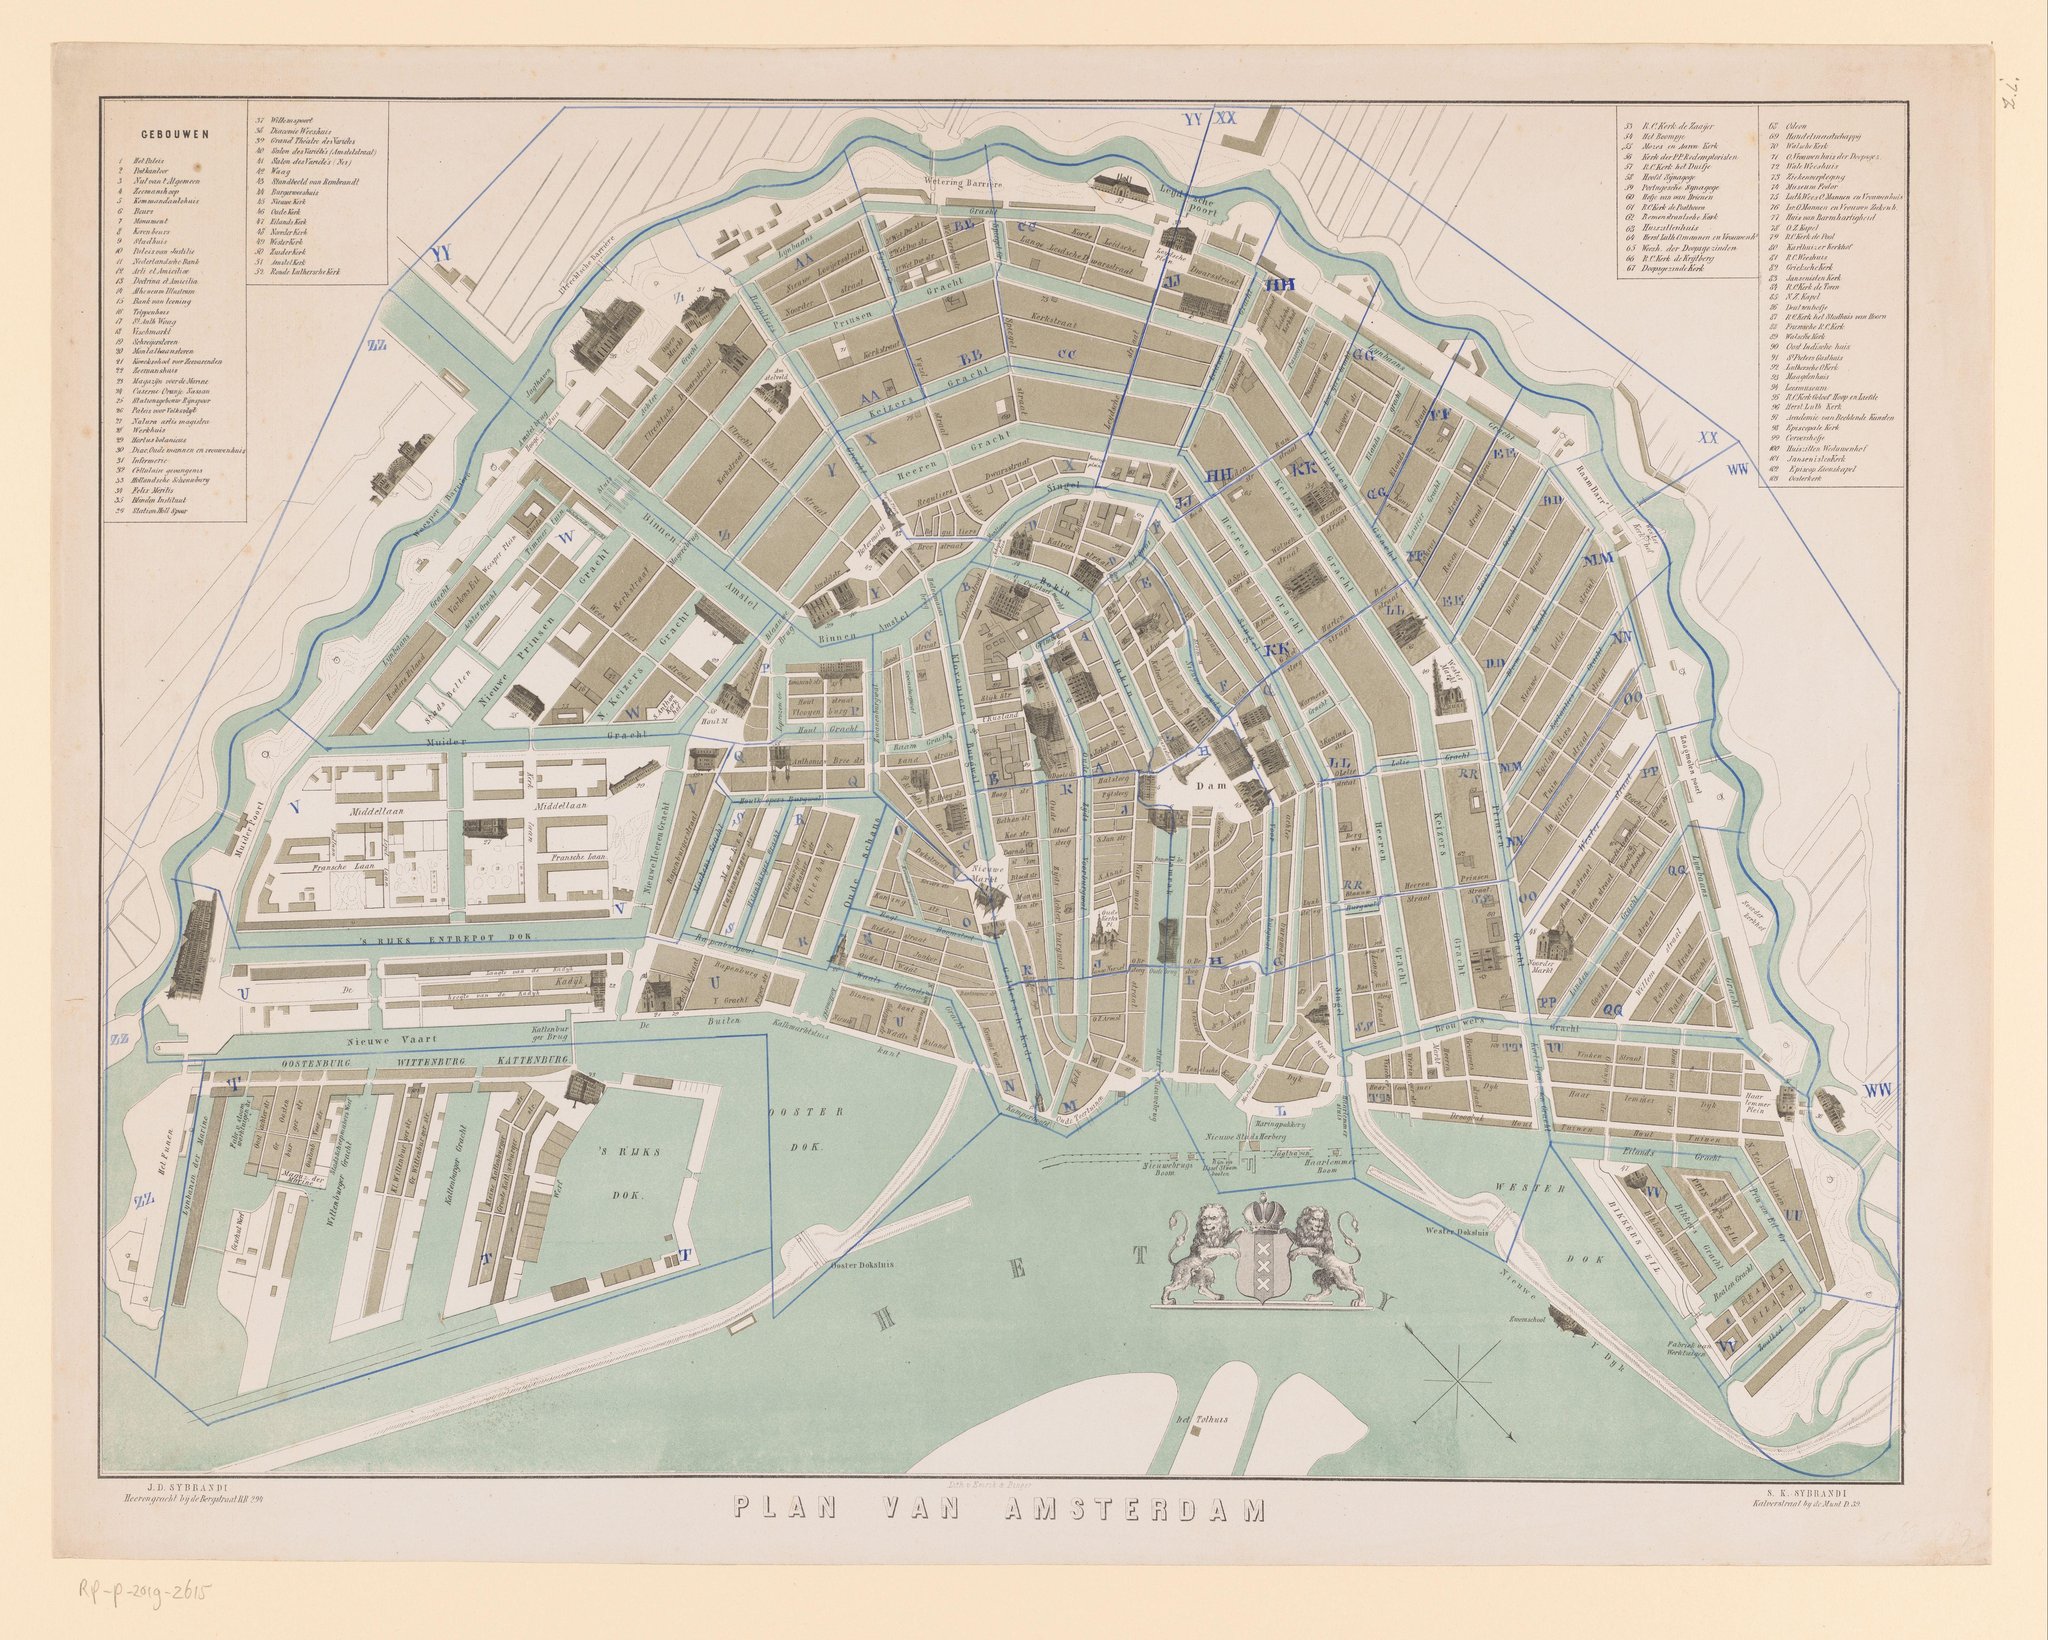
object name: print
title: Plattegrond van Amsterdam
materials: ink, paper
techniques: lithograph, pen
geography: haarlem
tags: maps of cities, amsterdam